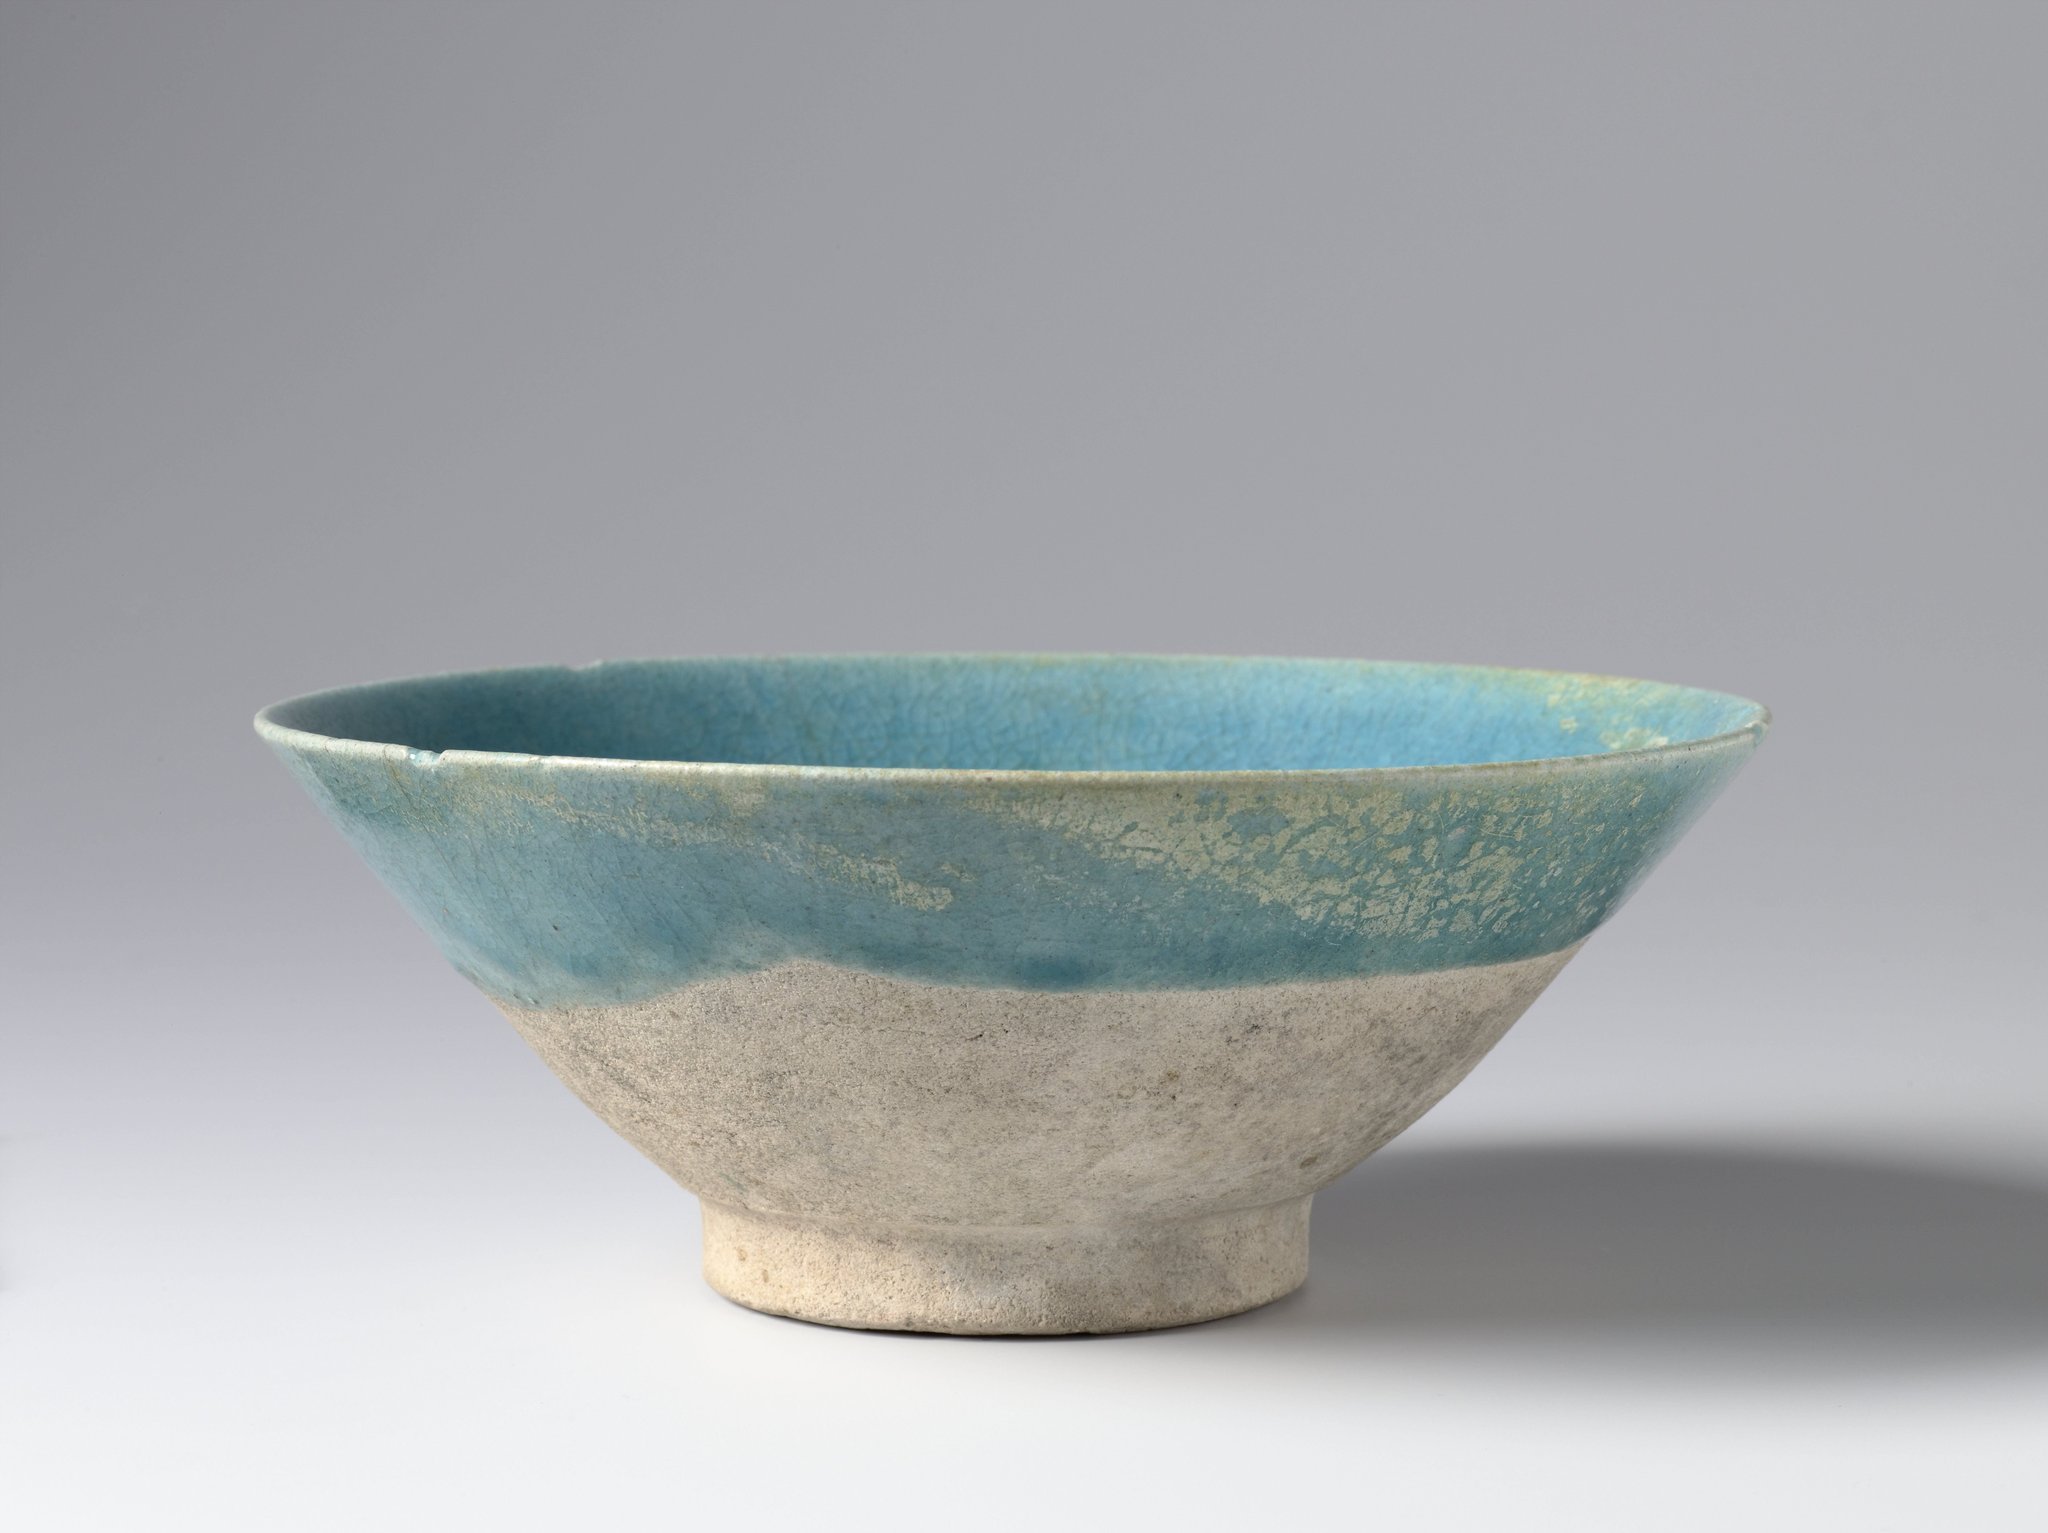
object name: bowl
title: Bowl with a turquoise glaze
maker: Anonymous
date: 1175-1224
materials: earthenware, glaze, quartz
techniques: firing, turning, vitrification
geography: afghanistan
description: Kom van kwarts-fritgoed met drie inkepingen in de mondrand en bedekt met een monochroom turquoise alkaliglazuur.